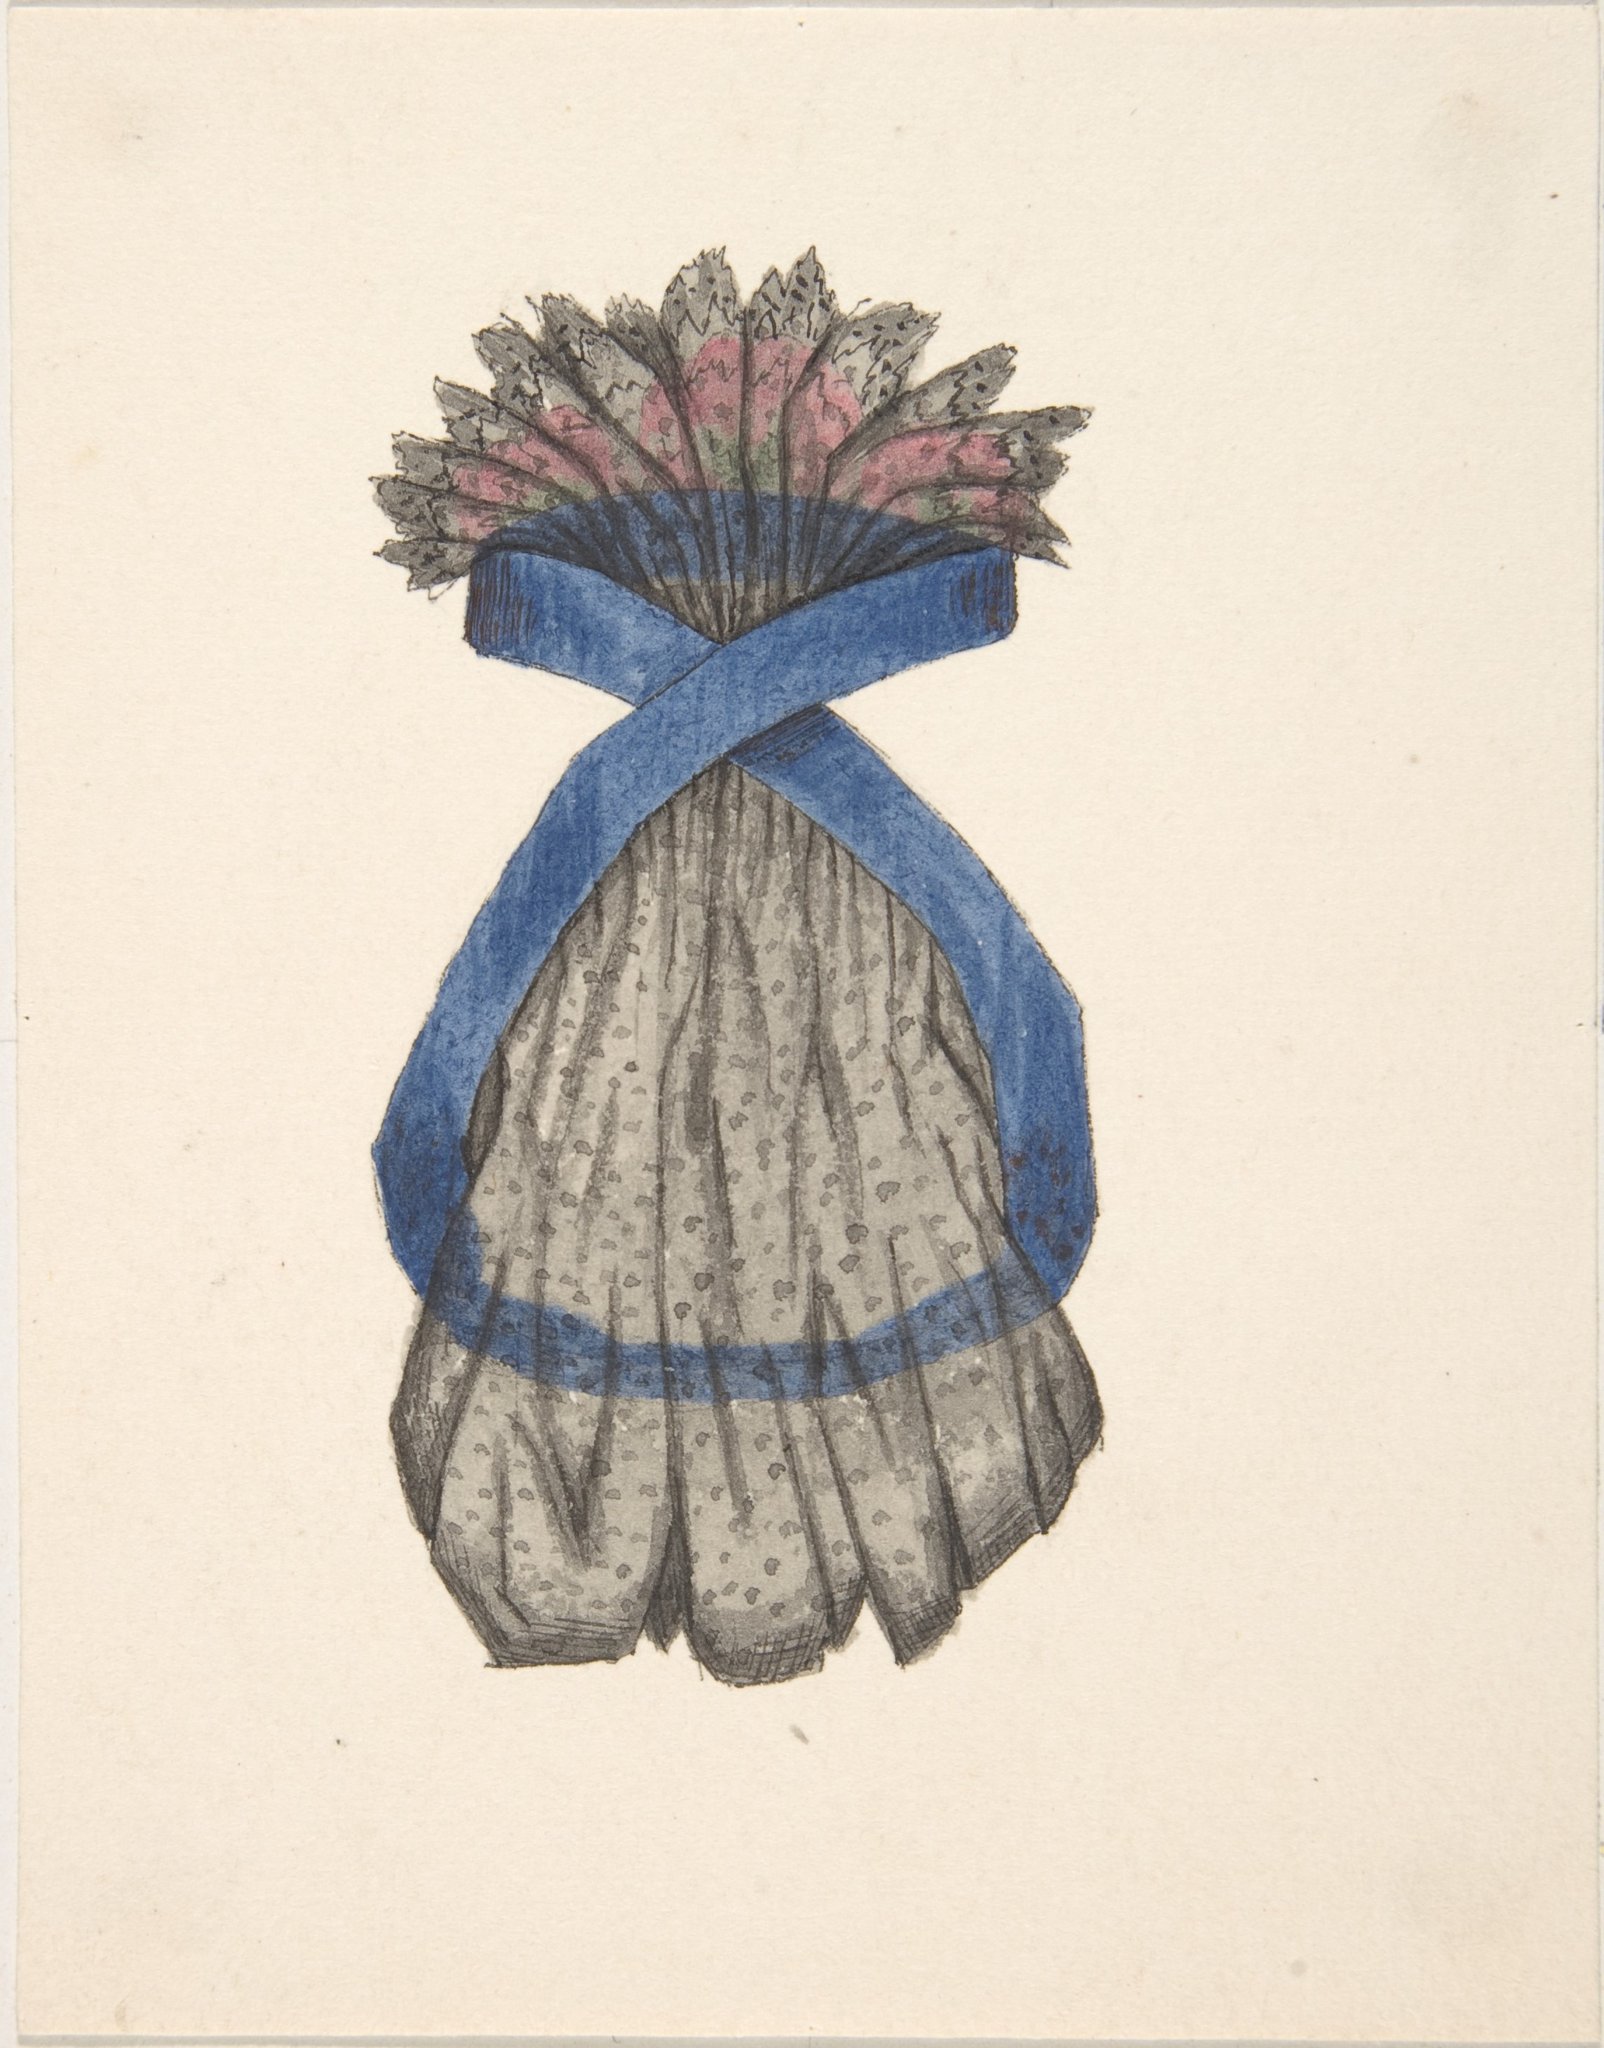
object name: drawing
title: A Hat on a Stand, Viewed from the Back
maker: auguste félix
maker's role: artist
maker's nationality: french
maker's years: 1860-1870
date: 1865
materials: ink, watercolor, paper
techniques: brush, pen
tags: hats